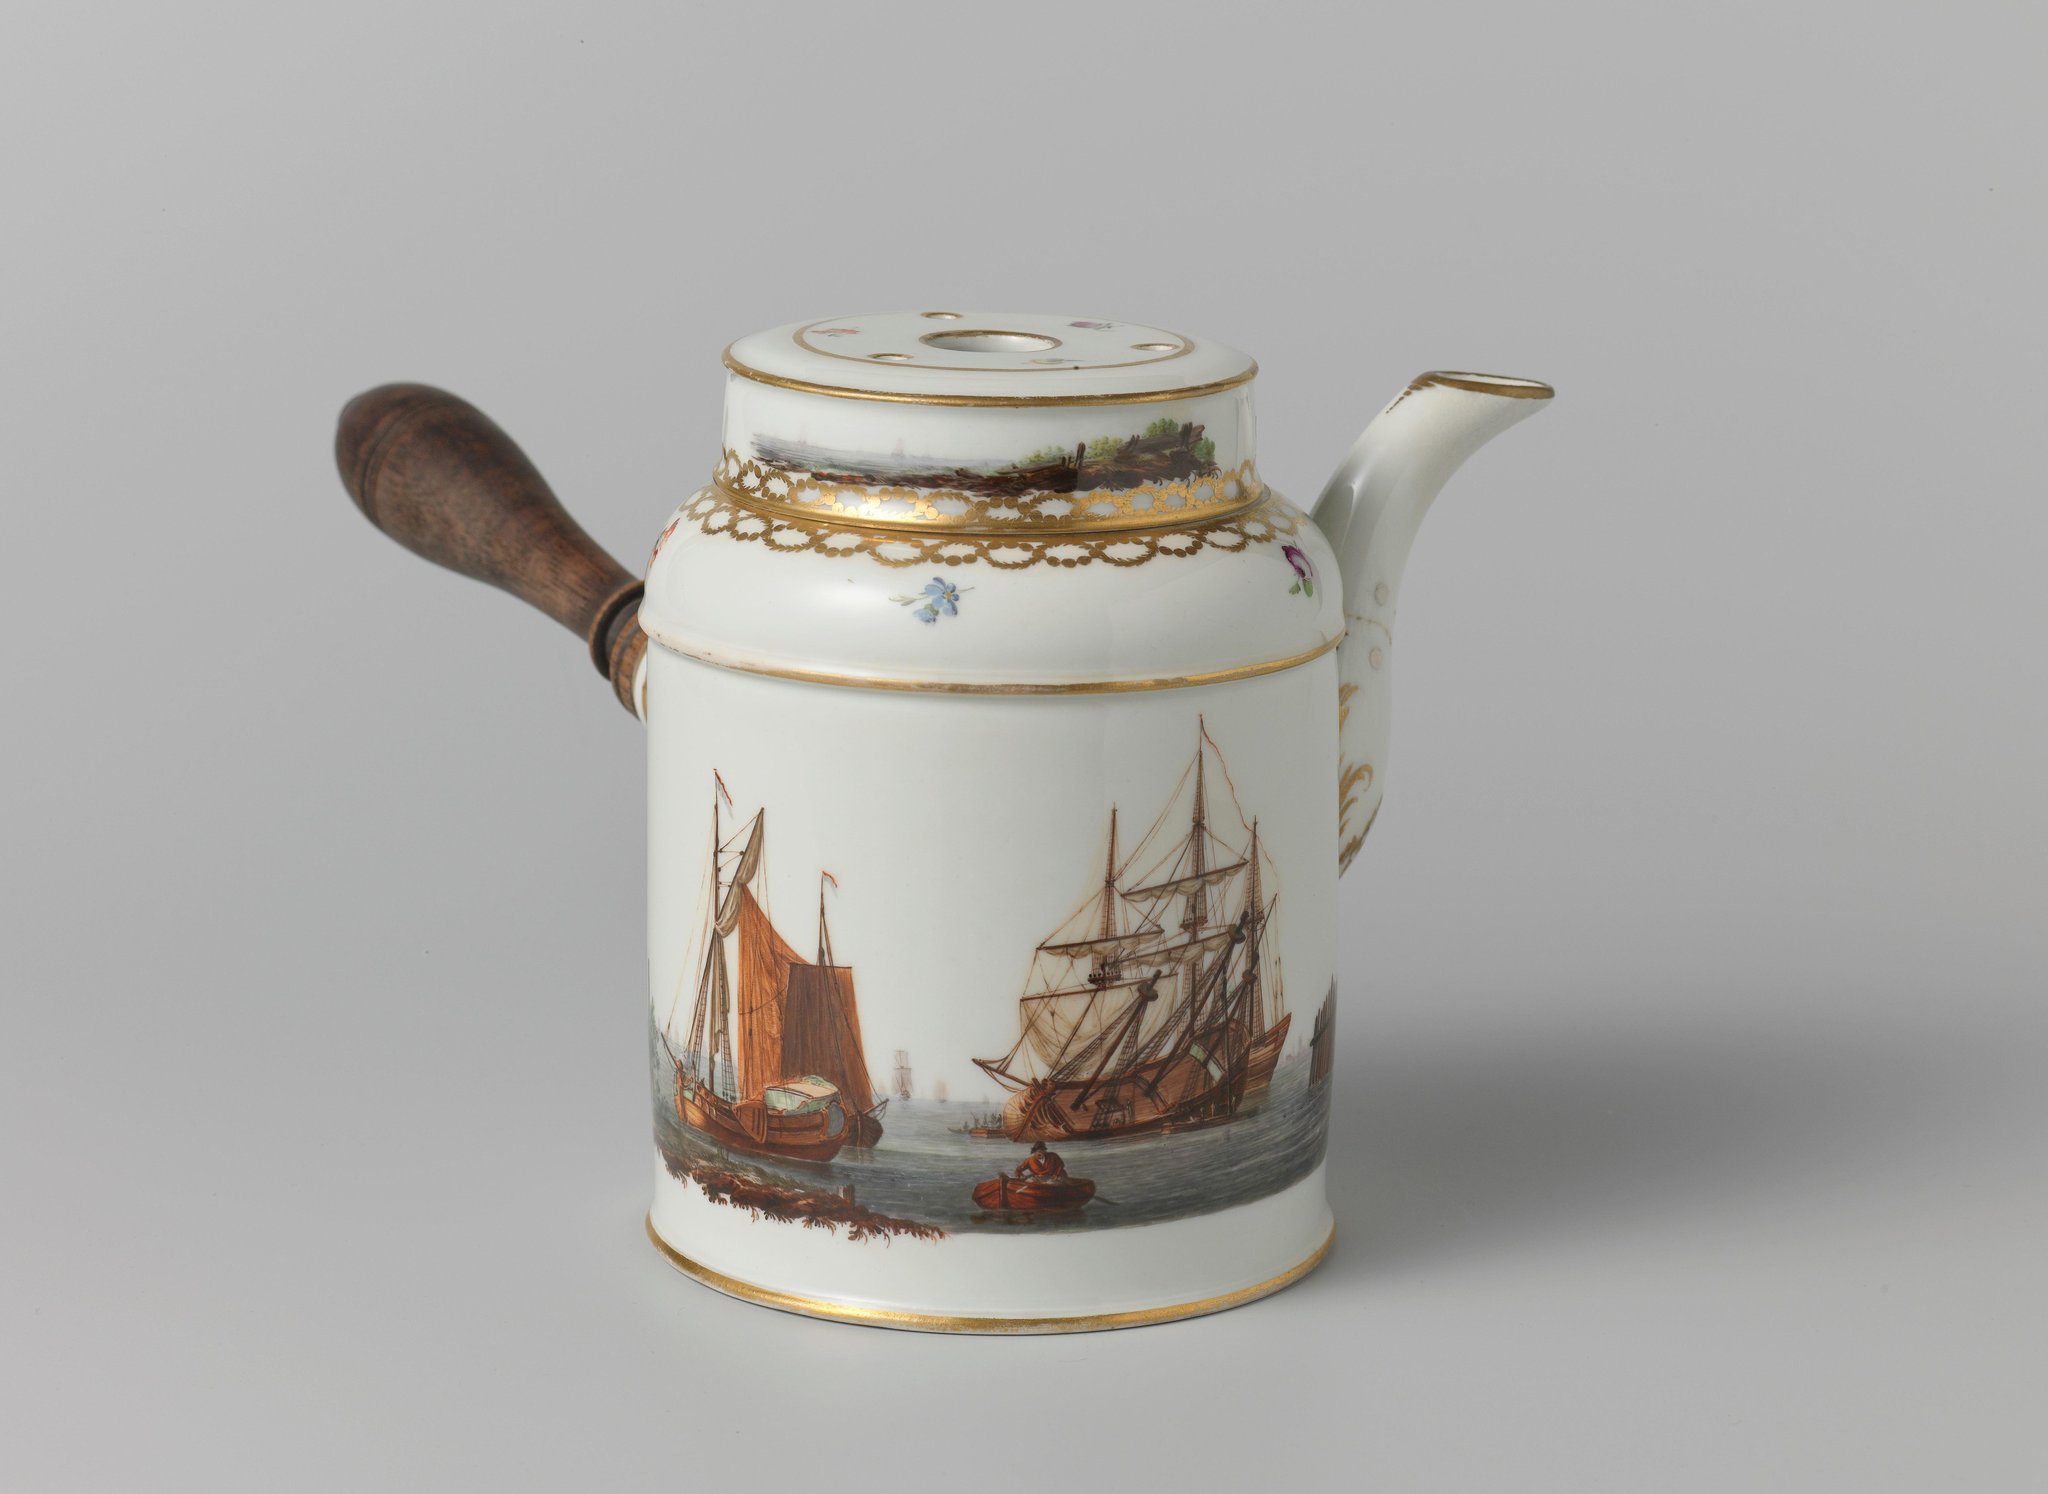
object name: chocolate pot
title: Chocoladekan met houten handvat, beschilderd met riviergezicht met schepen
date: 1784-1814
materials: porcelain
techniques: painted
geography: amstel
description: Chocoladekan cilindrisch van vorm met een houten handvat De versiering bestaat uit een veelkleurig riviergezicht met schepen. Strooibloemen en gouden bladranken. Gemerkt: Amstel in blauw onder het glazuur en ingegrift L1 met ster.